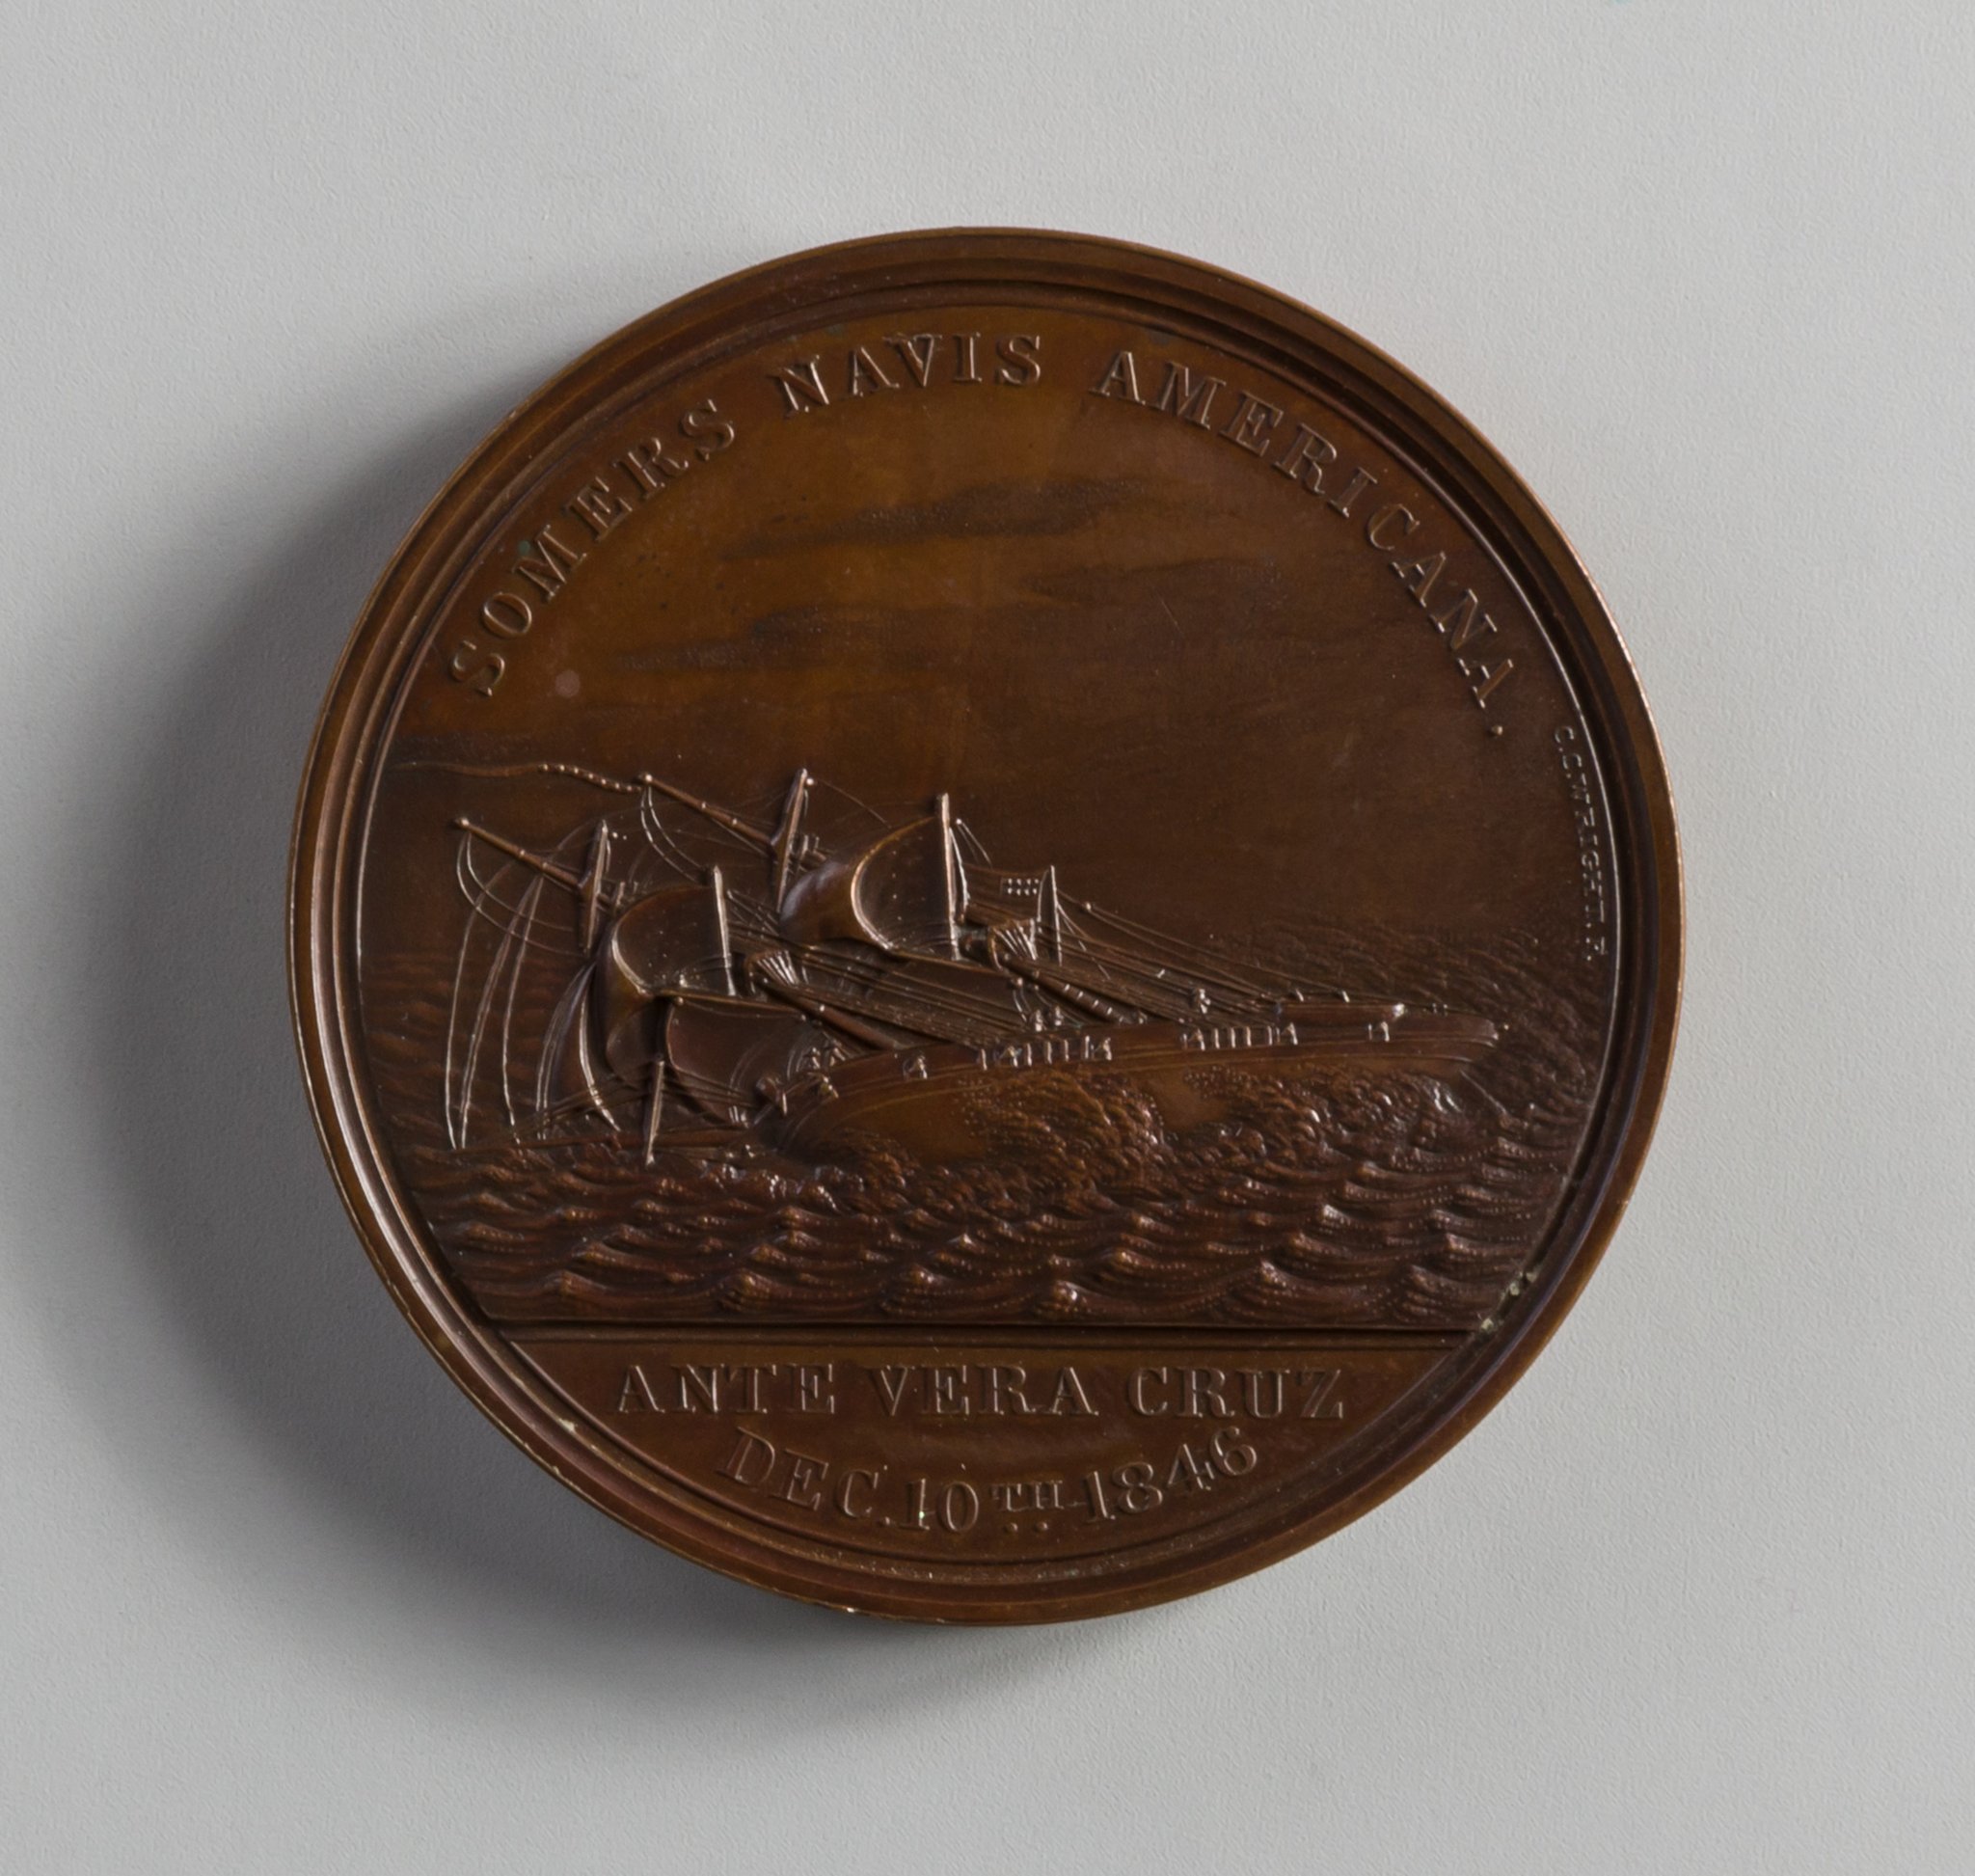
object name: medal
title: "Somers Medal"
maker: charles cushing wright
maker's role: maker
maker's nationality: american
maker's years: 1796-1854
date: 1830-1870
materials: bronze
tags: ships